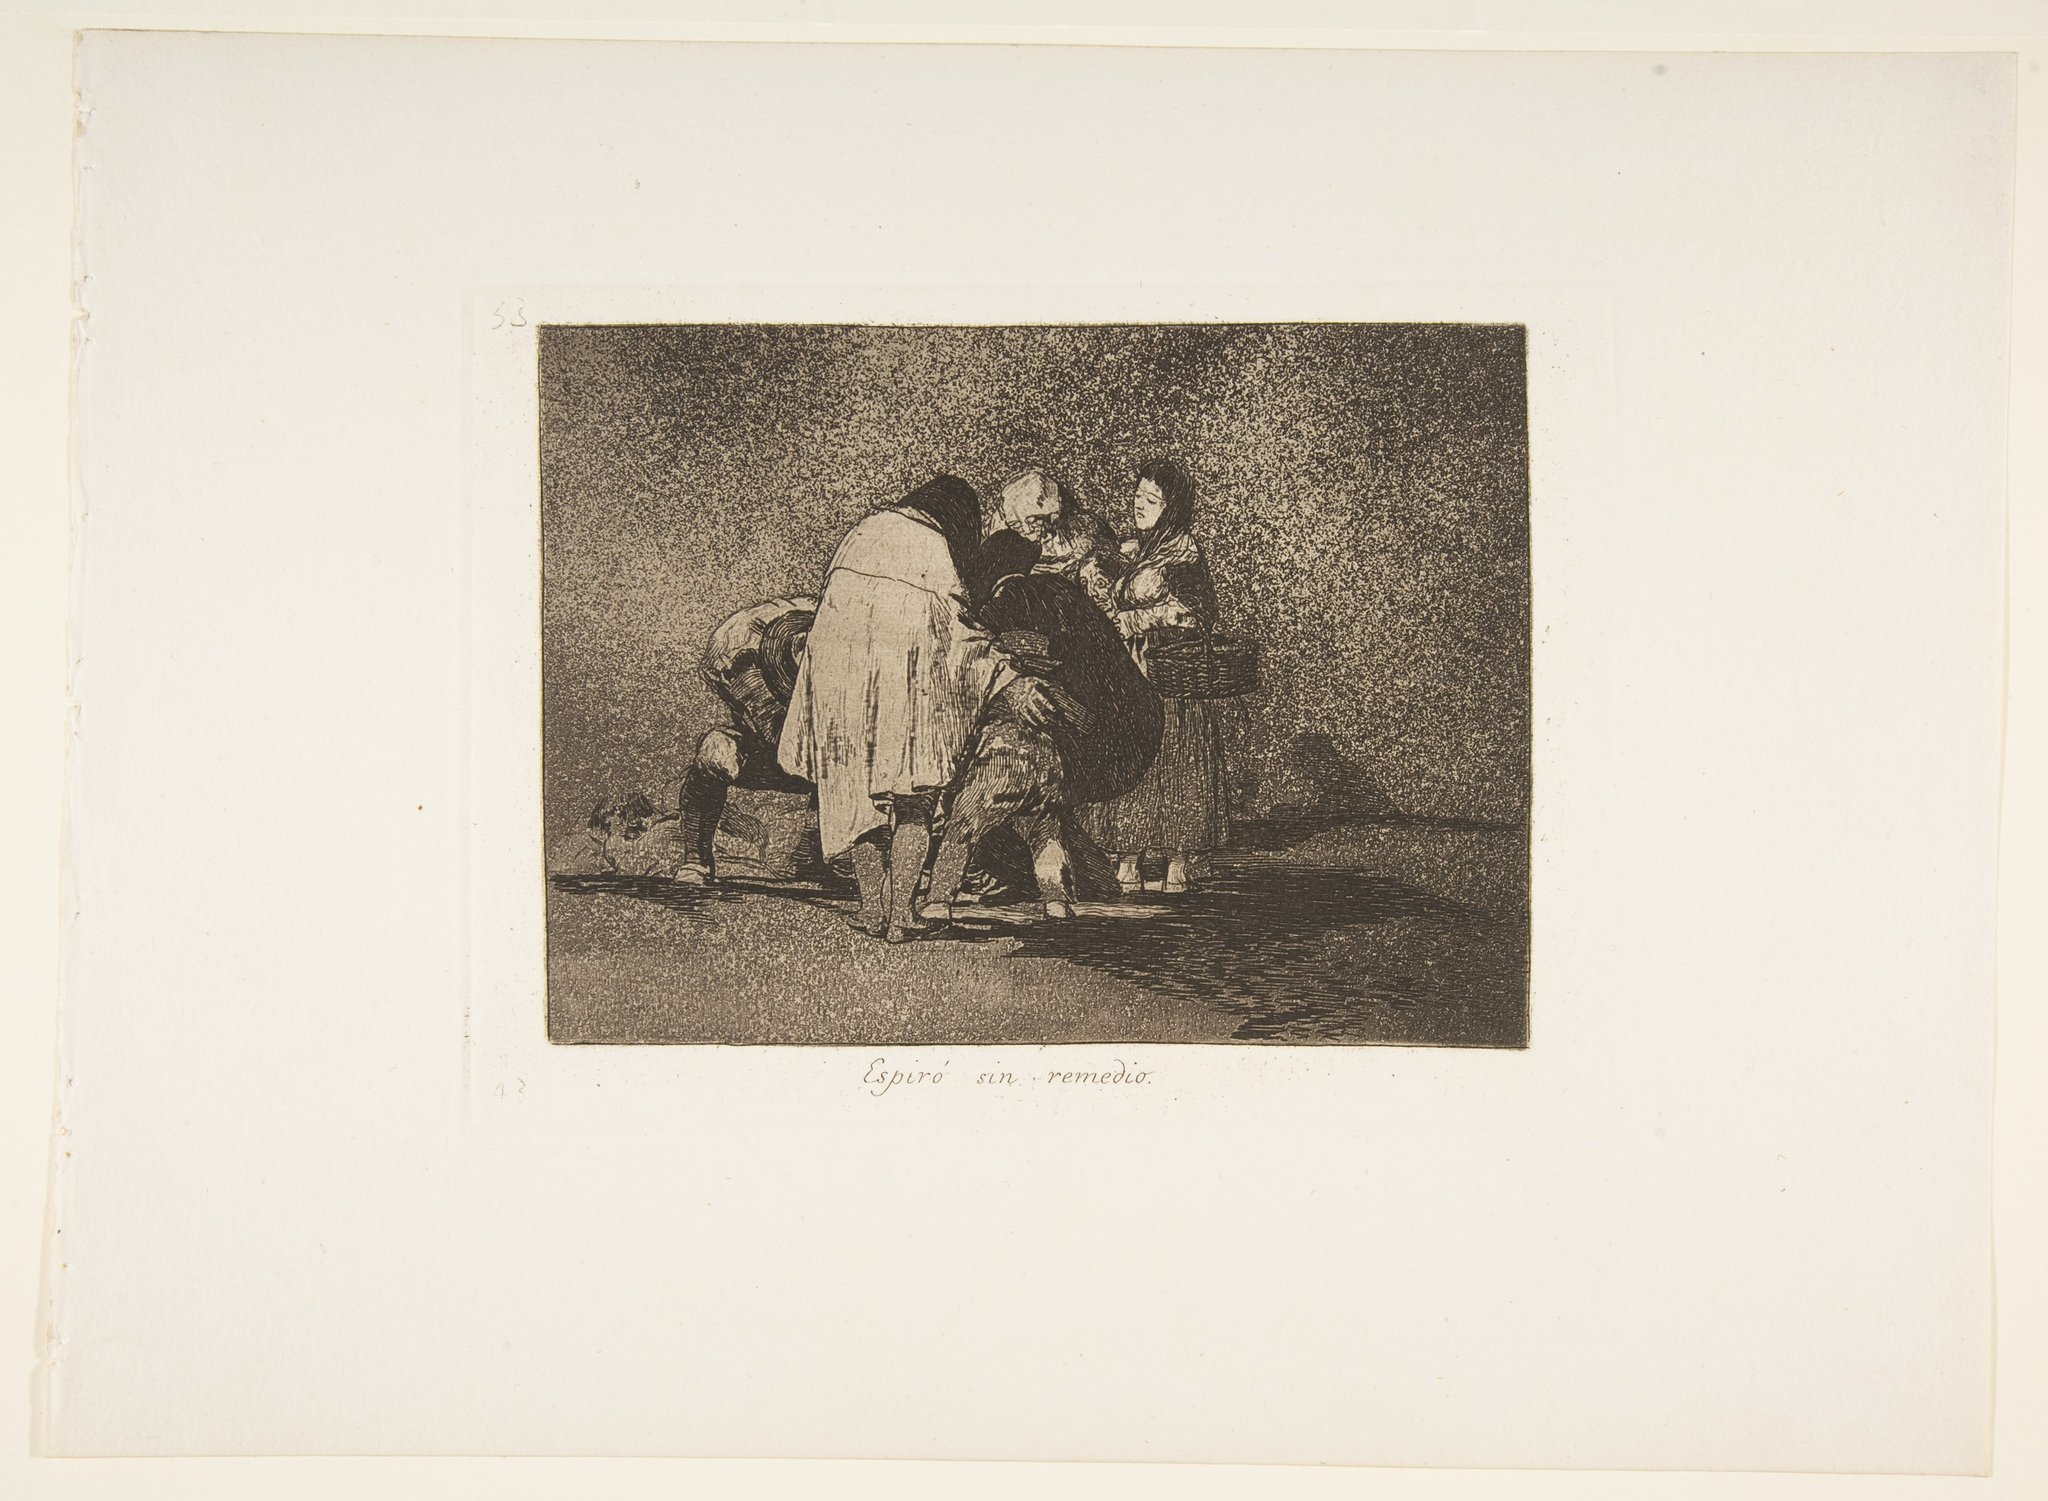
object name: print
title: Plate 53 from "The Disasters of War" (Los Desastres de la Guerra): 'There was nothing to be done and he died' (Espiró sin remedio)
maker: goya (francisco de goya y lucientes)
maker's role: artist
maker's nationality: spanish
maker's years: 1746-1828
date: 1811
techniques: aquatint, engraving, burnishing, etching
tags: men,women